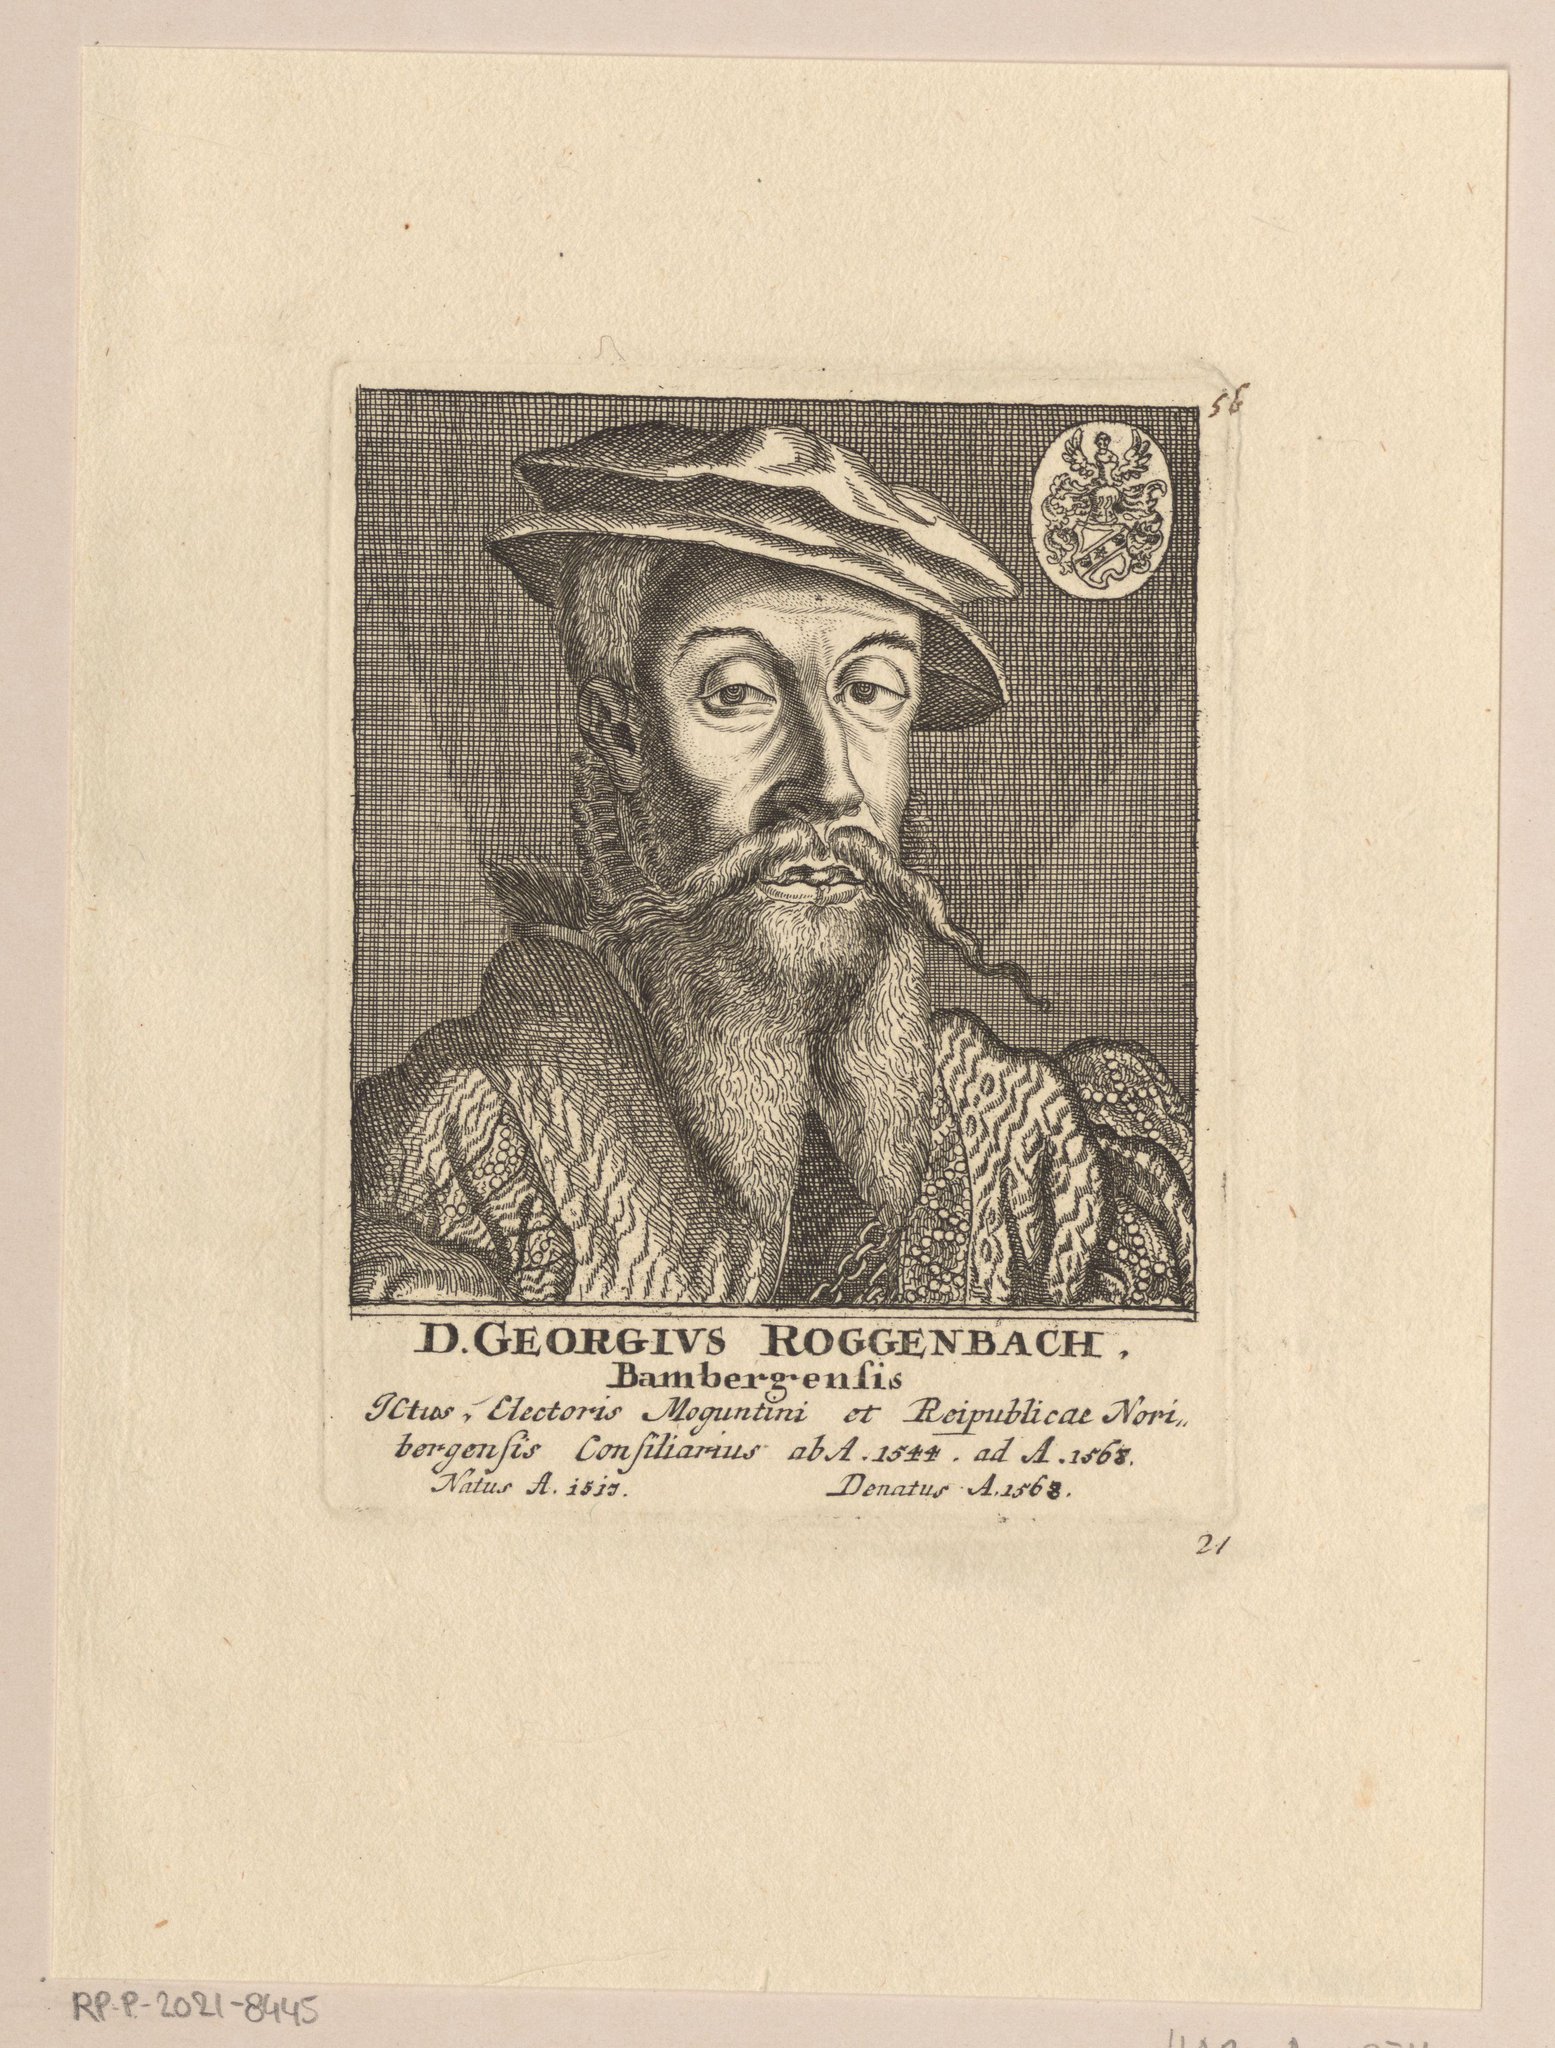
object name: print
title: Portret van Georg Roggenbach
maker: Anonymous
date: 1723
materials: paper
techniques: engraving, etching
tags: historical persons, armorial bearing, heraldry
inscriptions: collector's mark: Lugt 2228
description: Prent mogelijk uit: Rothscholtz, Friedrich. Icones consiliariorum de illustri republica Noribergensi (...). Neurenberg en Altdorf: erven Johann Daniel Tauber, 1723.